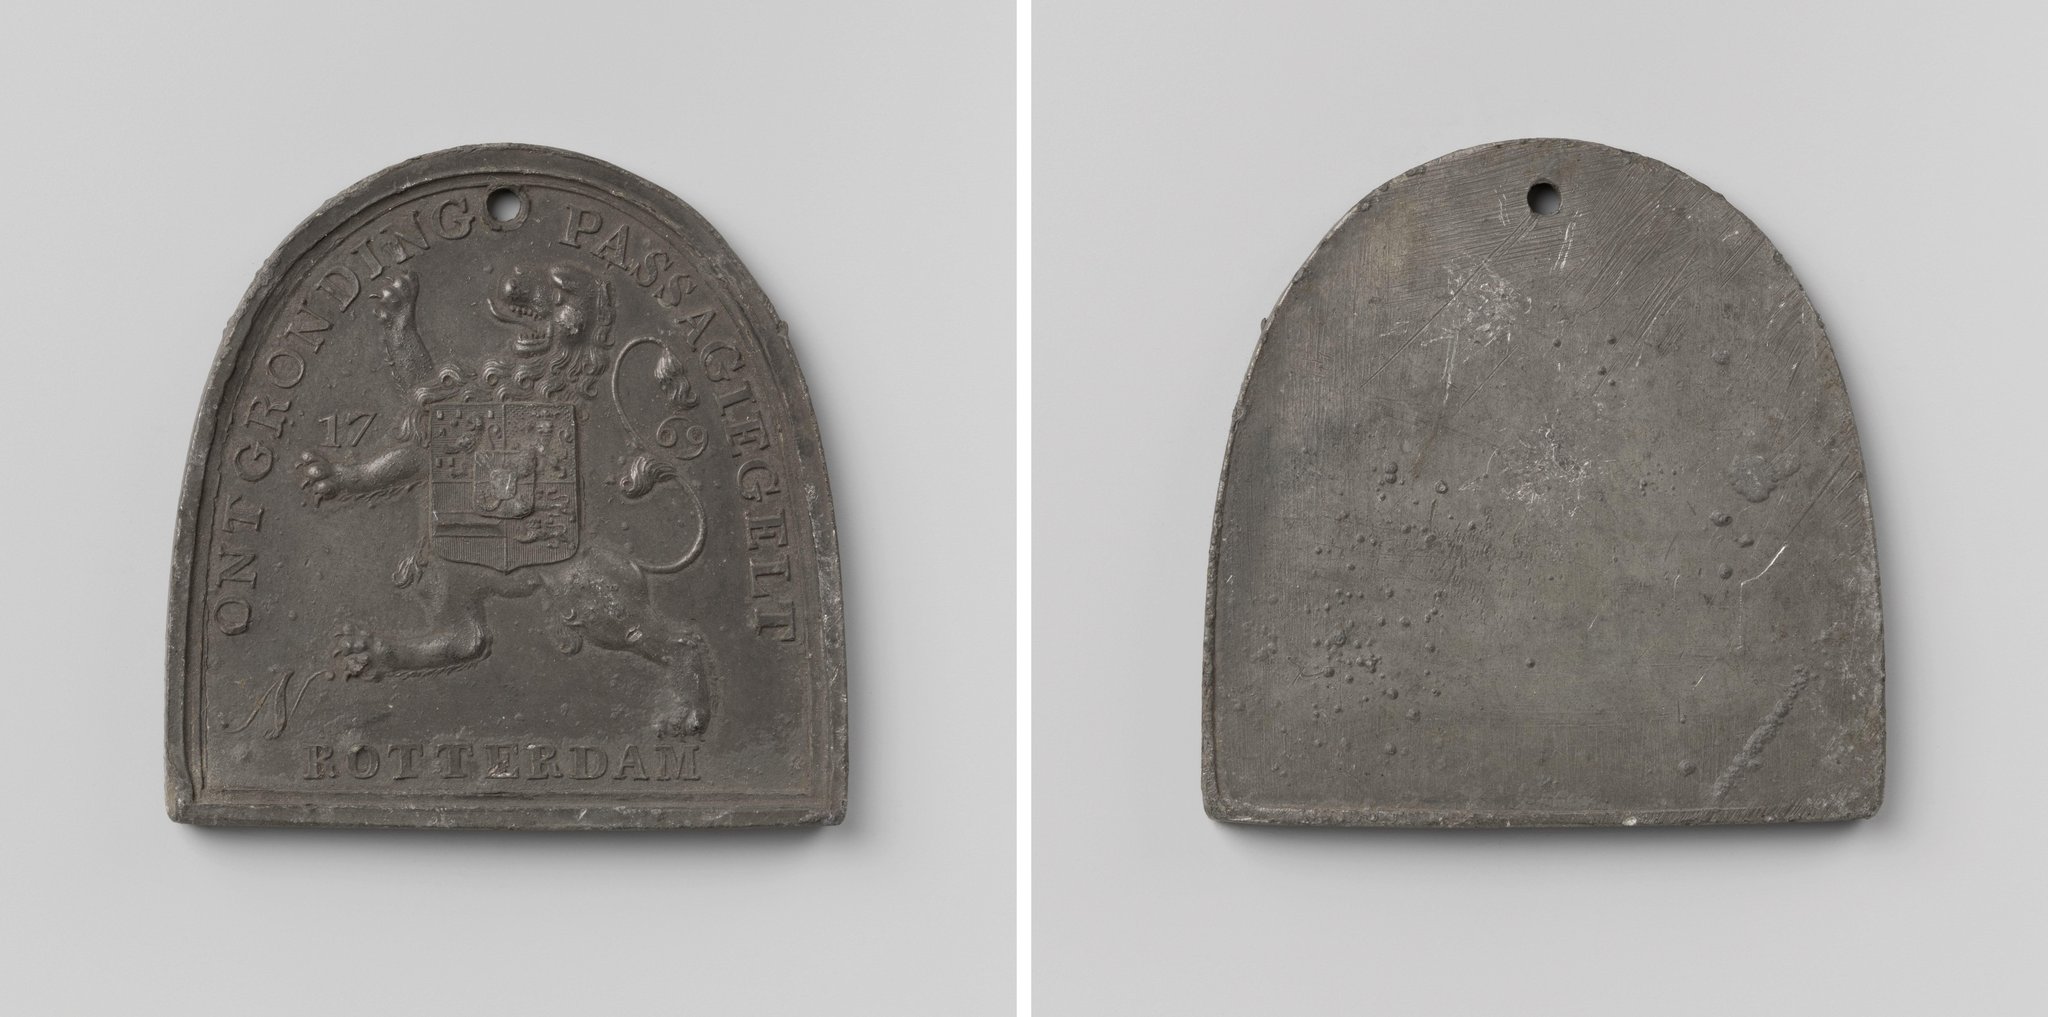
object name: ontgrondingspenning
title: Ontgronding te Rotterdam, penning bedoeld als bewijs voor turfdragers, -vullers of -tonners om turf in te mogen voeren uit de nieuw ontgronde venen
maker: Anonymous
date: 1769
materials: lead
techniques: casting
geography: rotterdam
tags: rotterdam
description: Eenzijdige loden penning met ronde boven- en rechthoekige onderzijde, en gat erin. Voorzijde: staande leeuw met wapenschild op borst tussen jaartal binnen omschrift. Keerzijde: blanco.